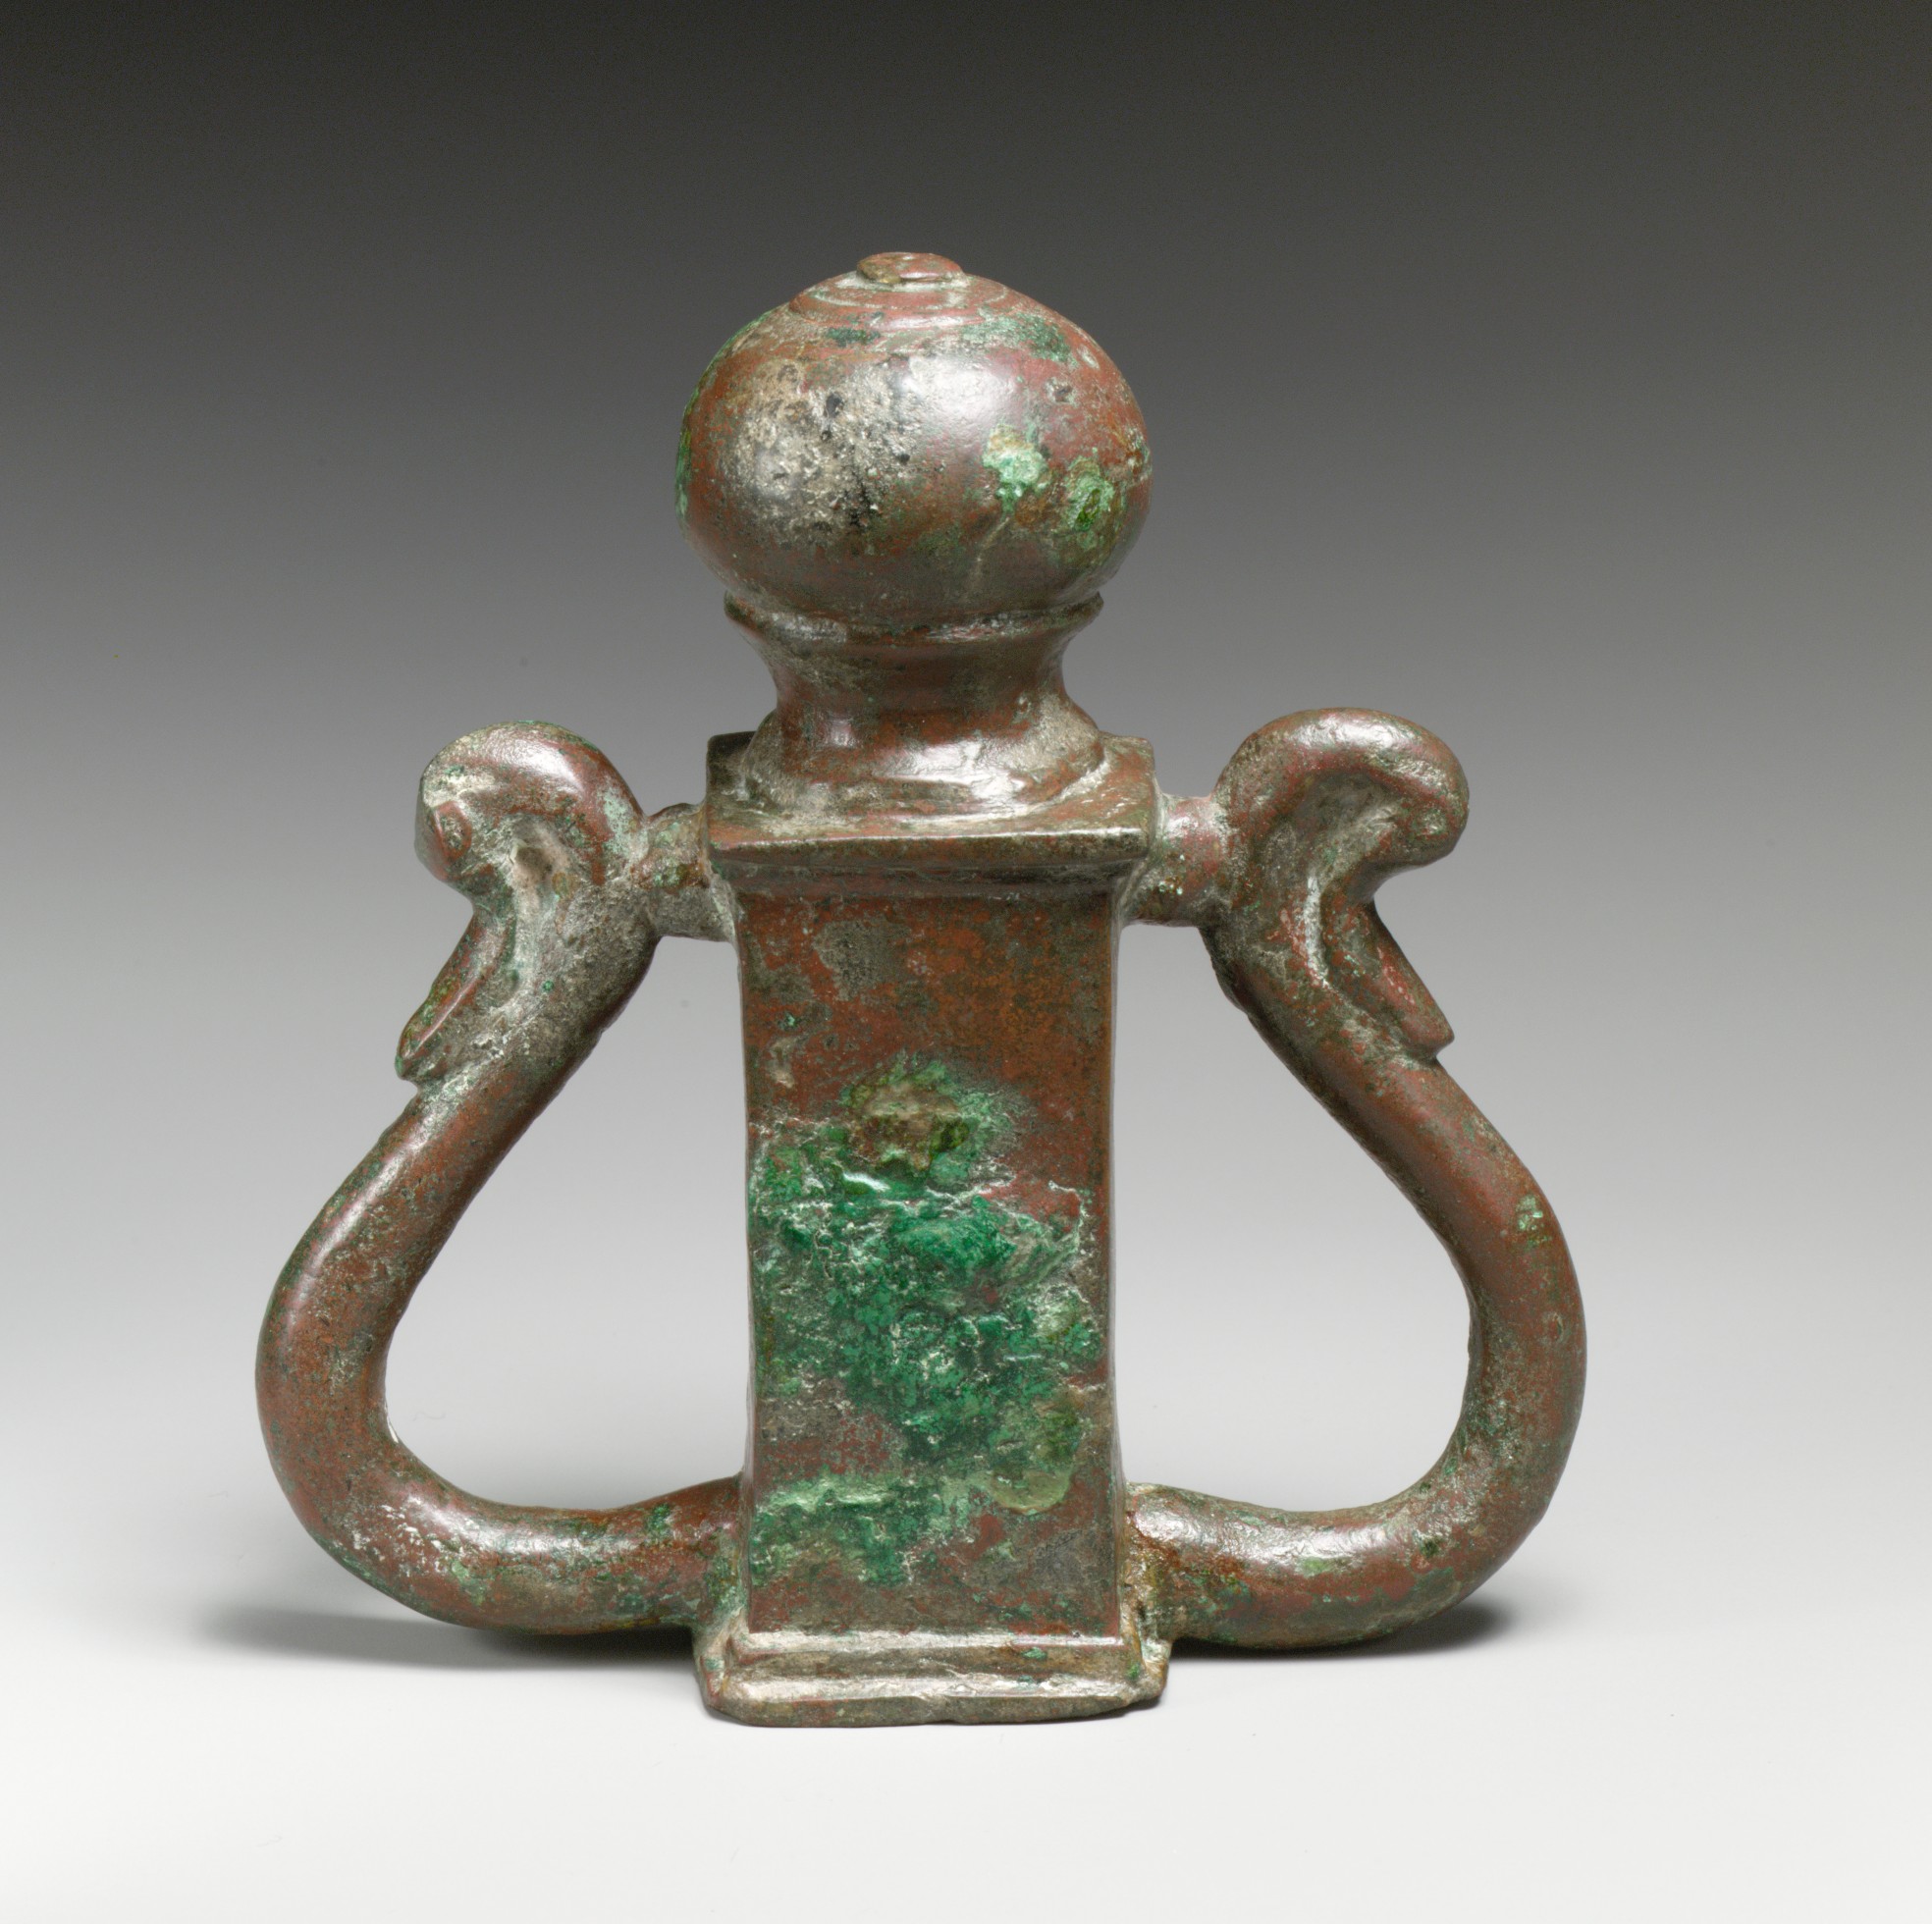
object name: chariot attachment with ducks' head finial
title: Two bronze chariot attachments with ducks' head finials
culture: roman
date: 201-400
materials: bronze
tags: ducks